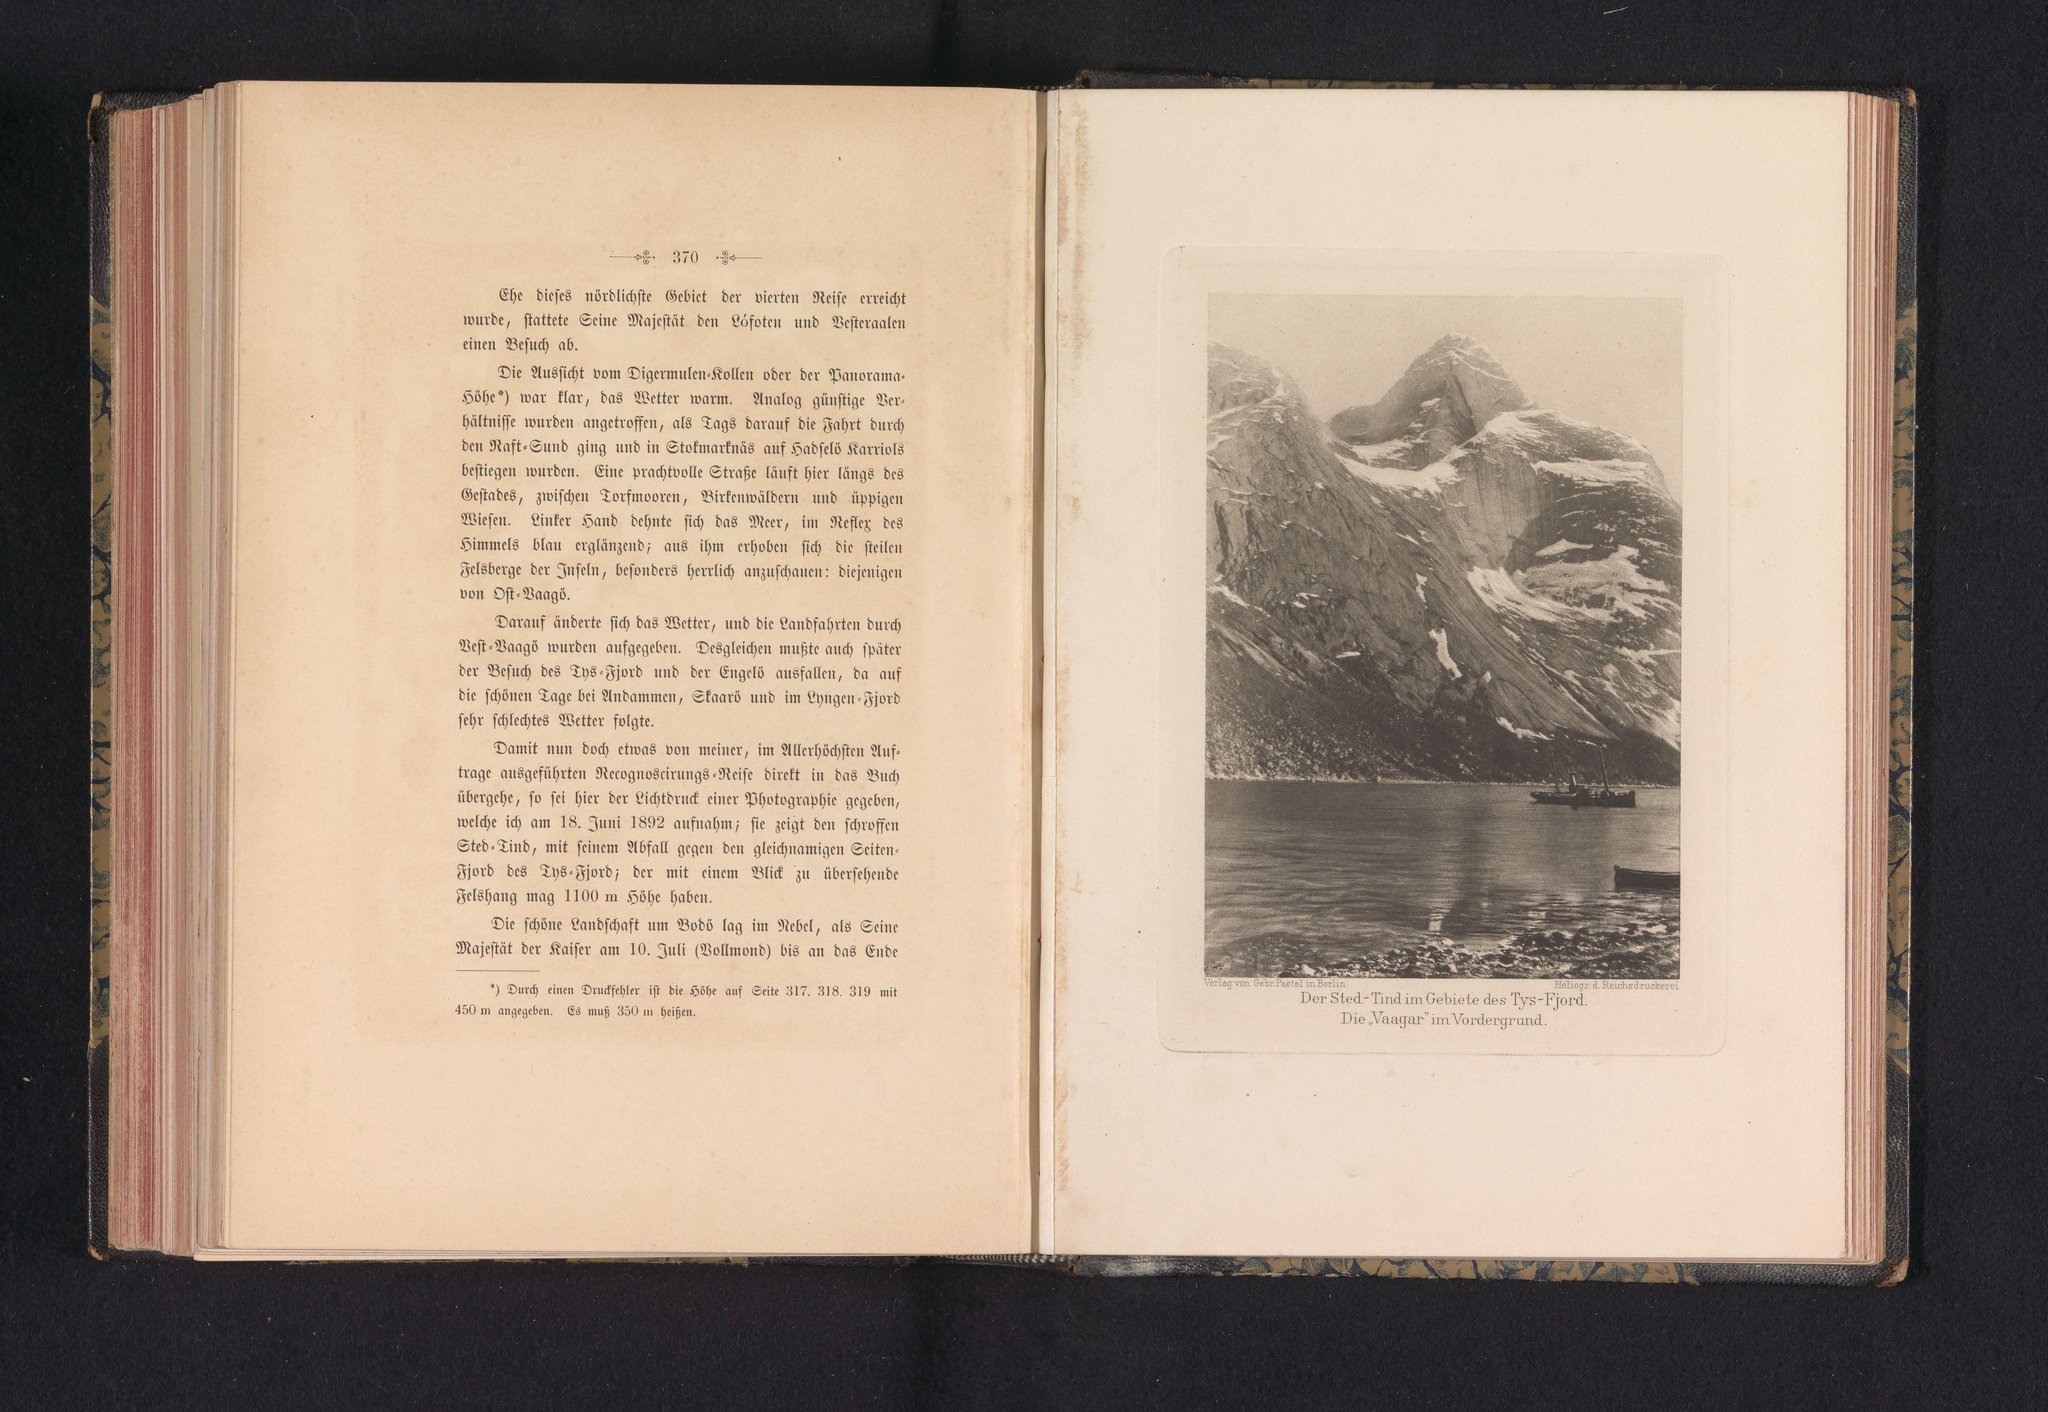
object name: photomechanical print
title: Gezicht op de Stetind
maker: paul güssfeldt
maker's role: alpinist, wiskundige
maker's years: 1840-1920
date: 1889-1892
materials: paper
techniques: photoaquatint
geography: berlin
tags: mountain-top, peak